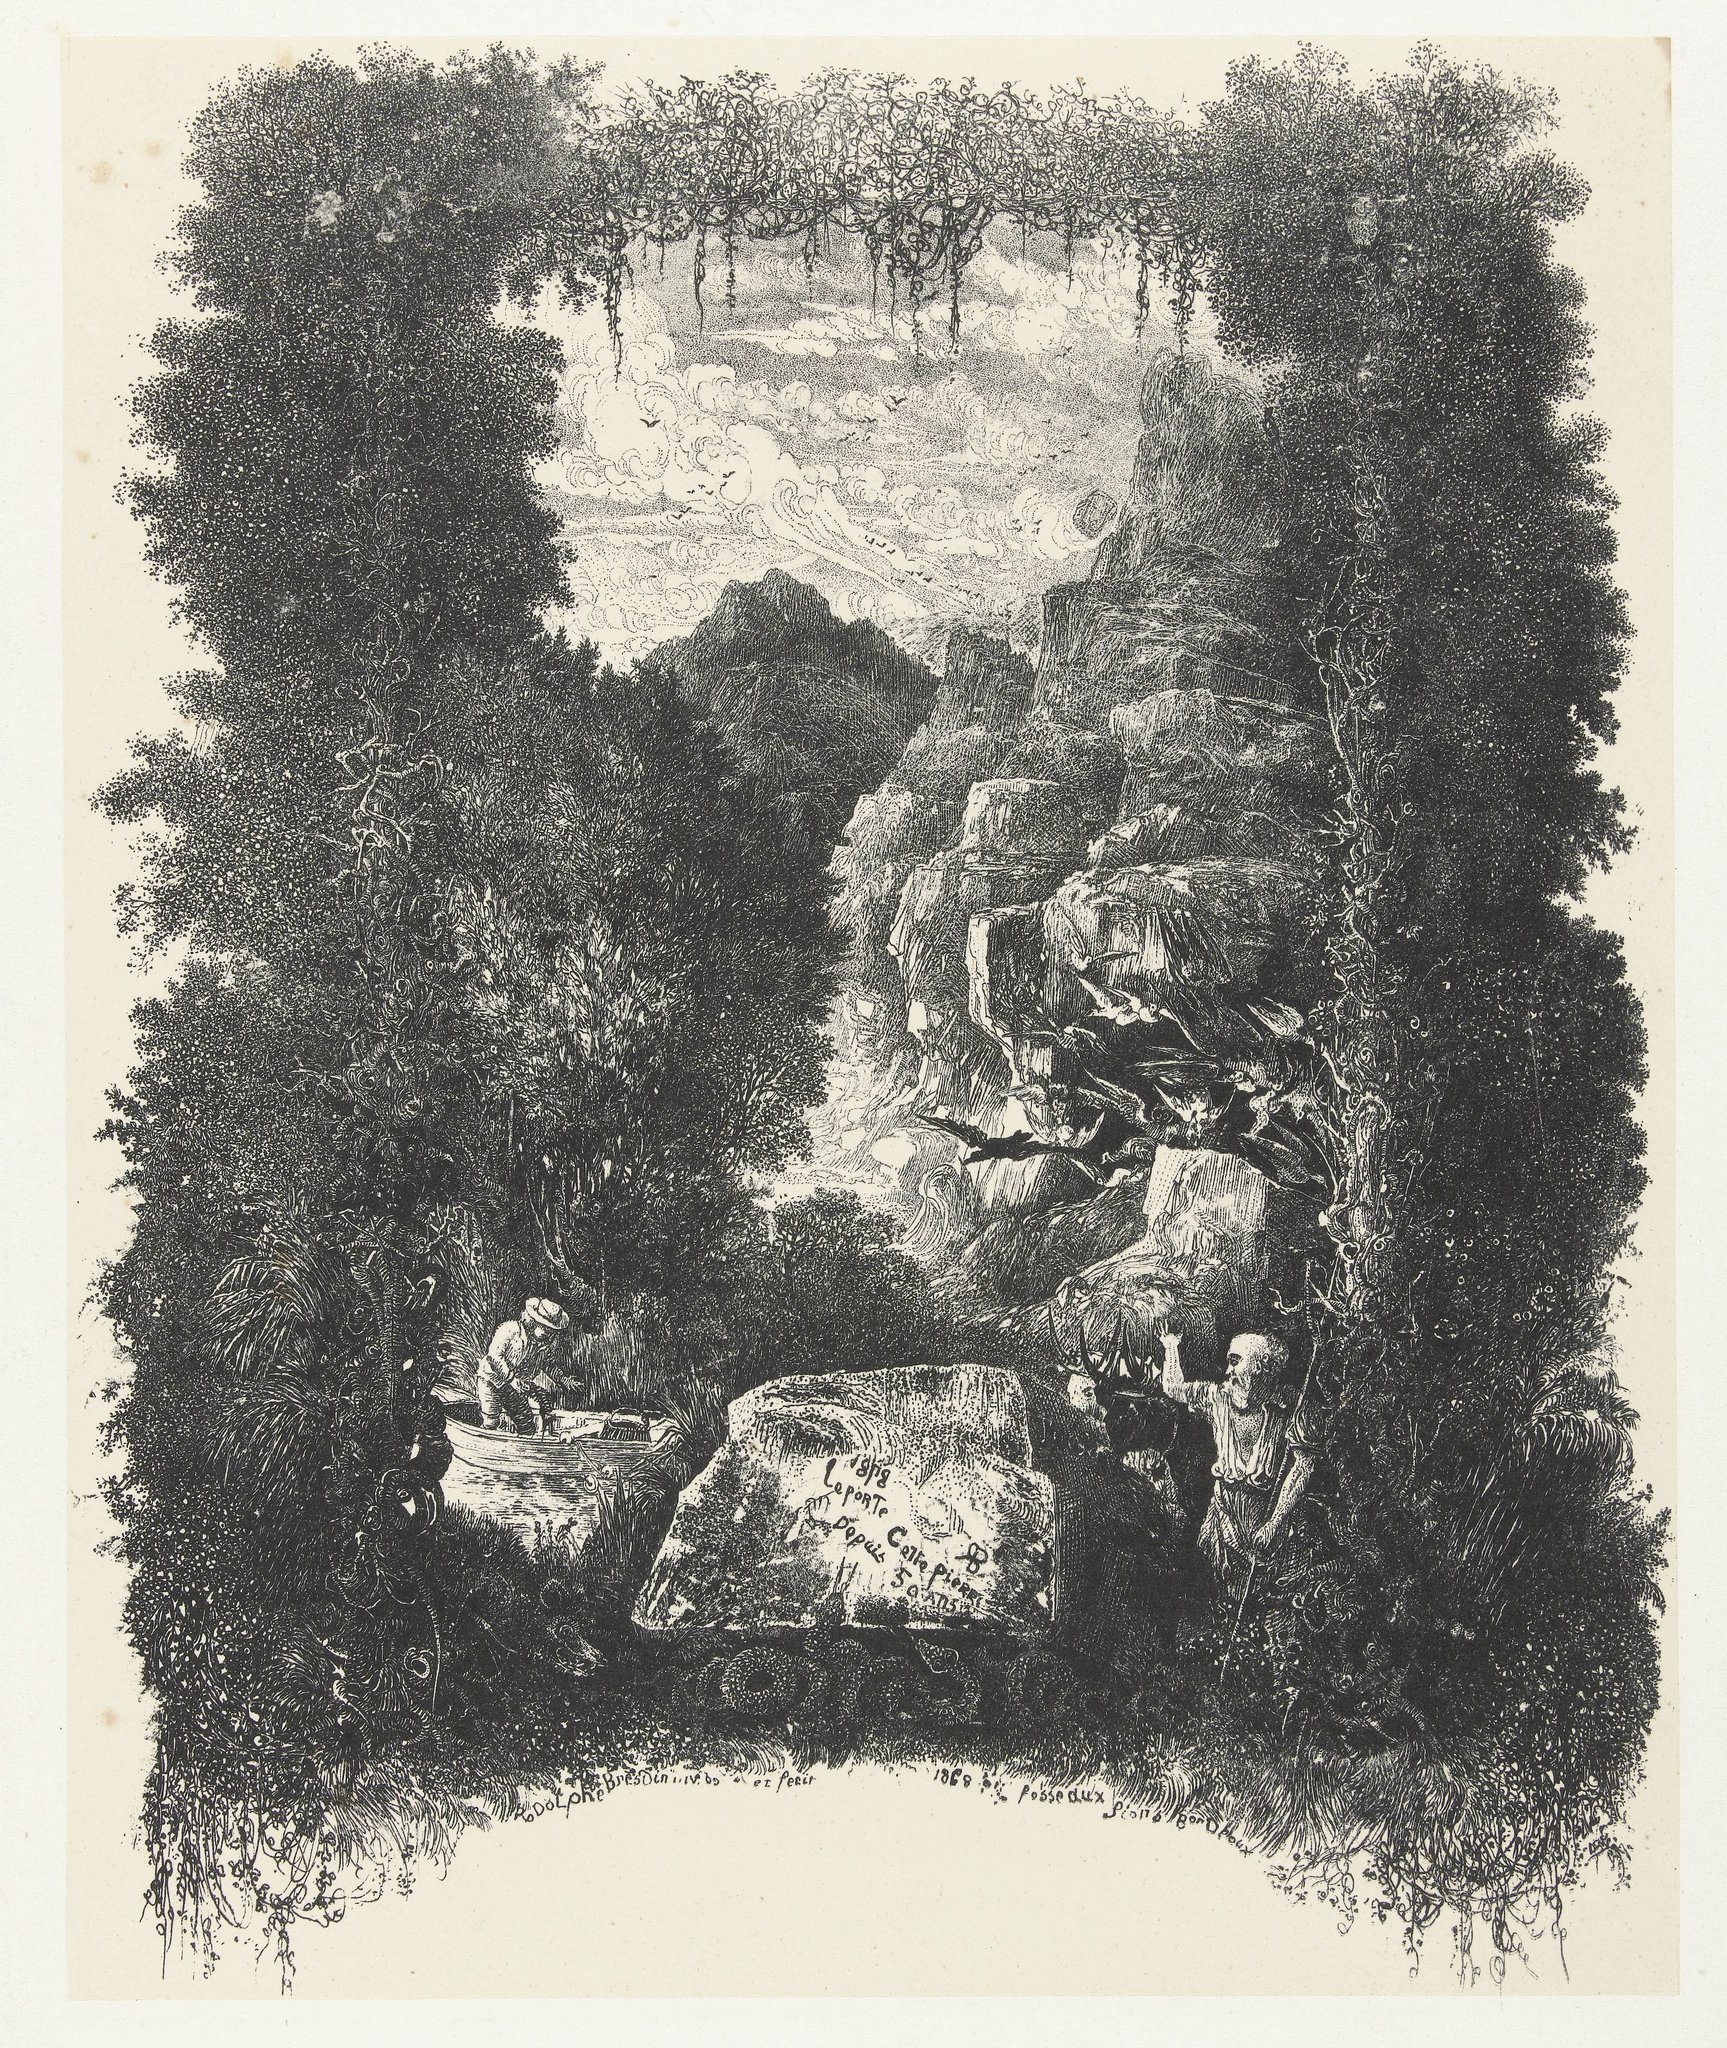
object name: print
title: Titelprent met landschap en figuren uit fabels en verhalen in omlijisting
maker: rodolphe bresdin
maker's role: draughtsman, print maker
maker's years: 1822-1885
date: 1868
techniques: printmaking, lithograph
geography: bordeaux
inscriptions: collector's mark: Lugt 2228, label, collector's mark:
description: Titelprent met landschap en twee figuren uit de fabels en verhalen in het boek waarvoor deze illustratie ontworpen werd. Rechts staat een man met runderen en links staat een man in een bootje. Vogels vliegen bij de opening van een grot in de rotswand op de achtergrond. Het geheel is gevat in een rechthoekige omlijsting samengesteld uit gevlochten takken en fijn gebladerte. Op de grond ligt een grote steen met de tekst Je porte cette pierre depuis 50 ans. Daarvoor liggen twee slangen.